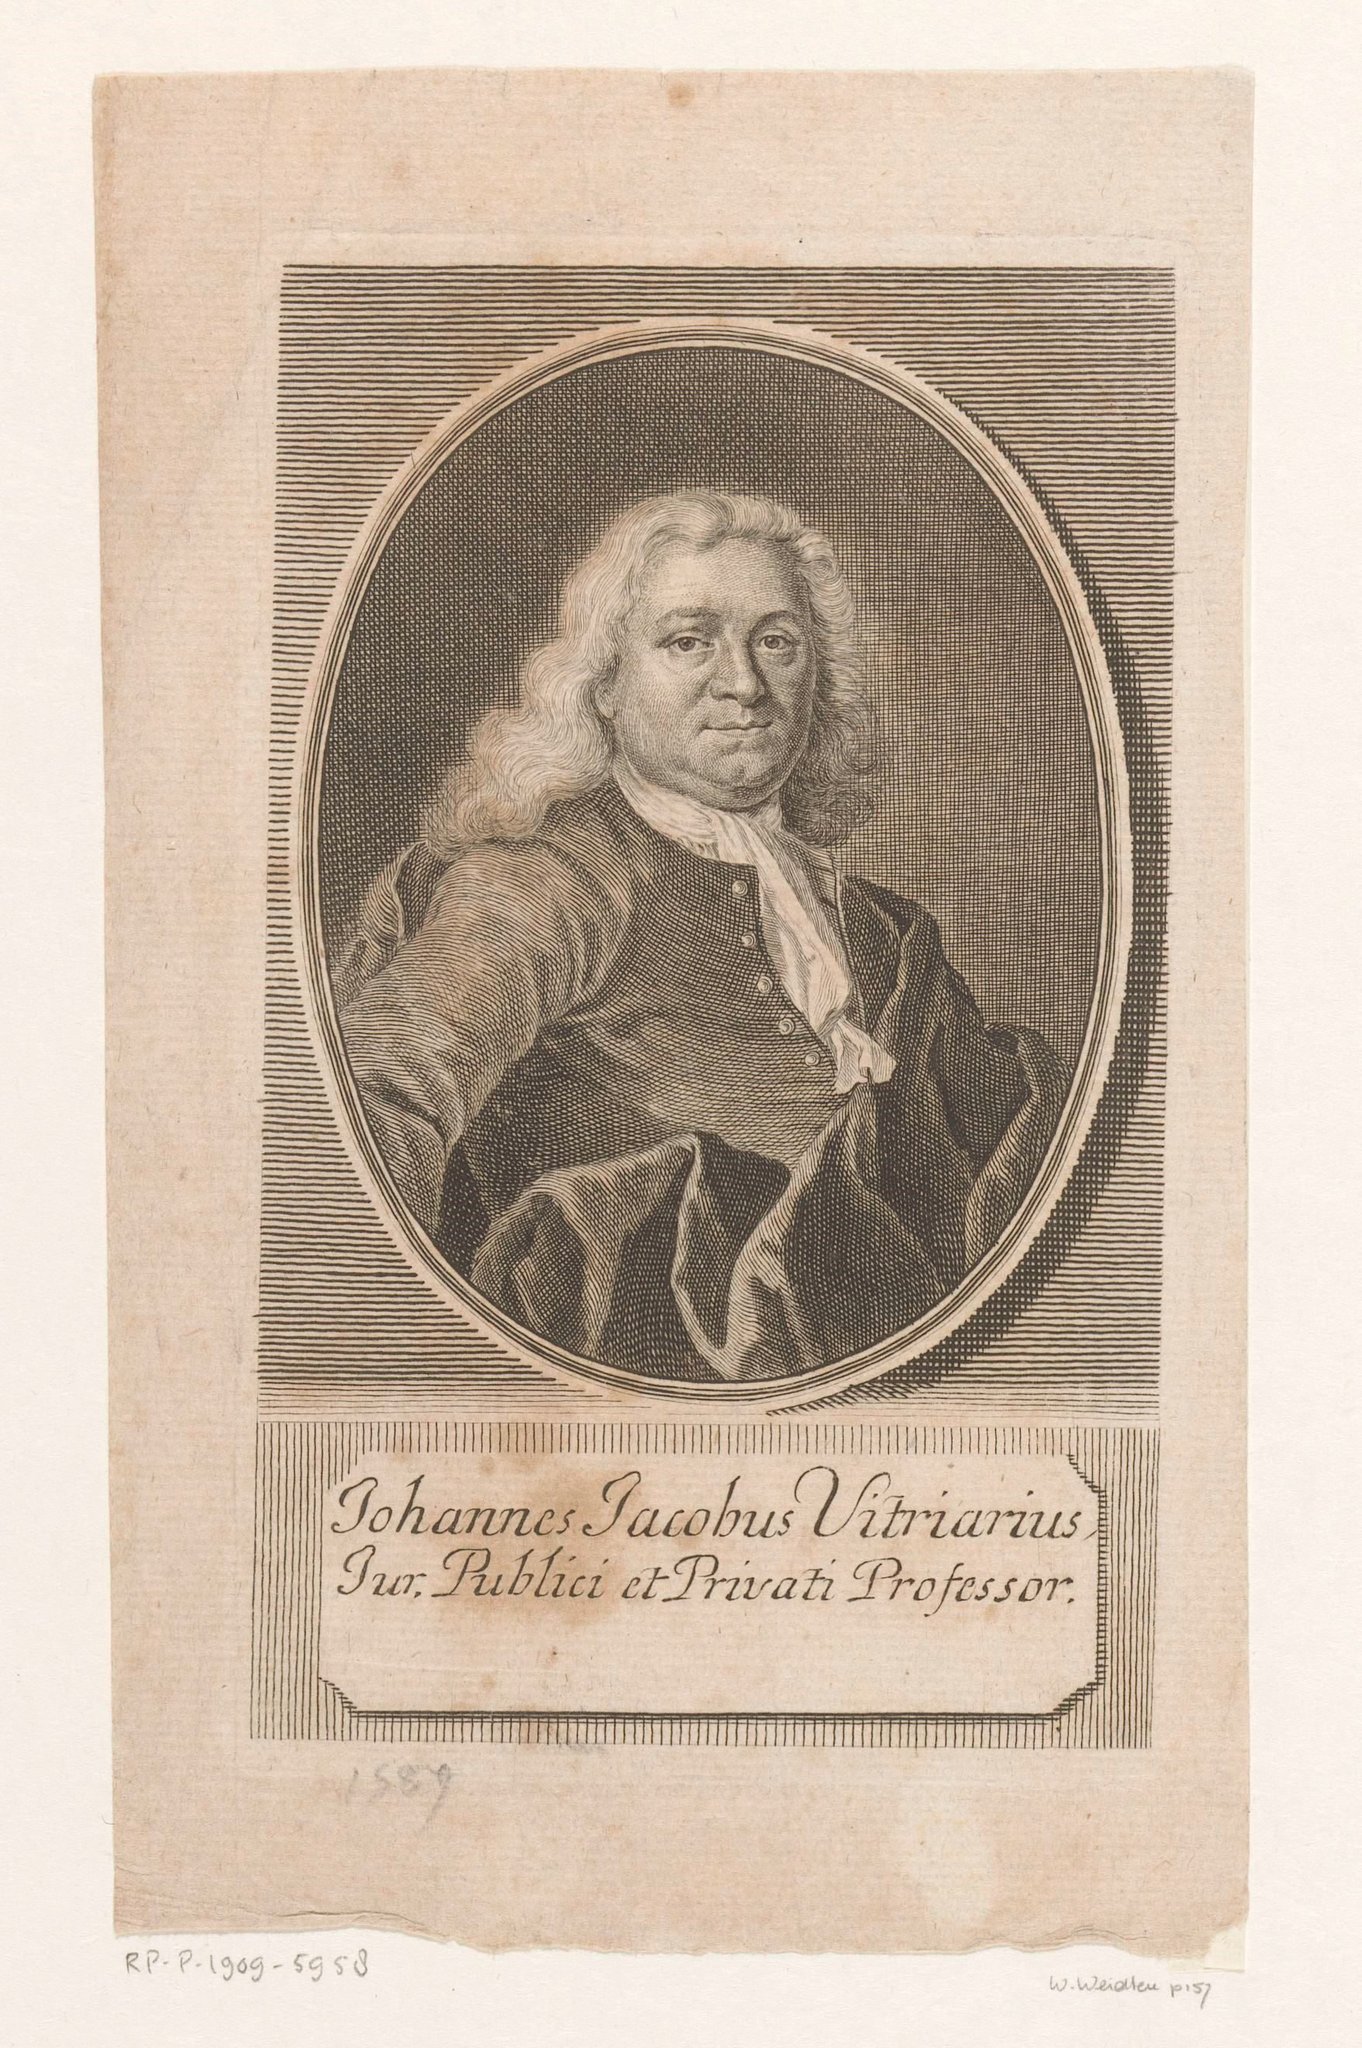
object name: print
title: Portret van Johannes Jacobus Vitriarius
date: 1732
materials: paper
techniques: engraving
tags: historical persons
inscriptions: collector's mark: Lugt 2228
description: Prent ook gebruikt in: Deutsche Acta Eruditorum (...). dl. 171. Leipzig: Johann Gottlieb Gleditsch, 1732.